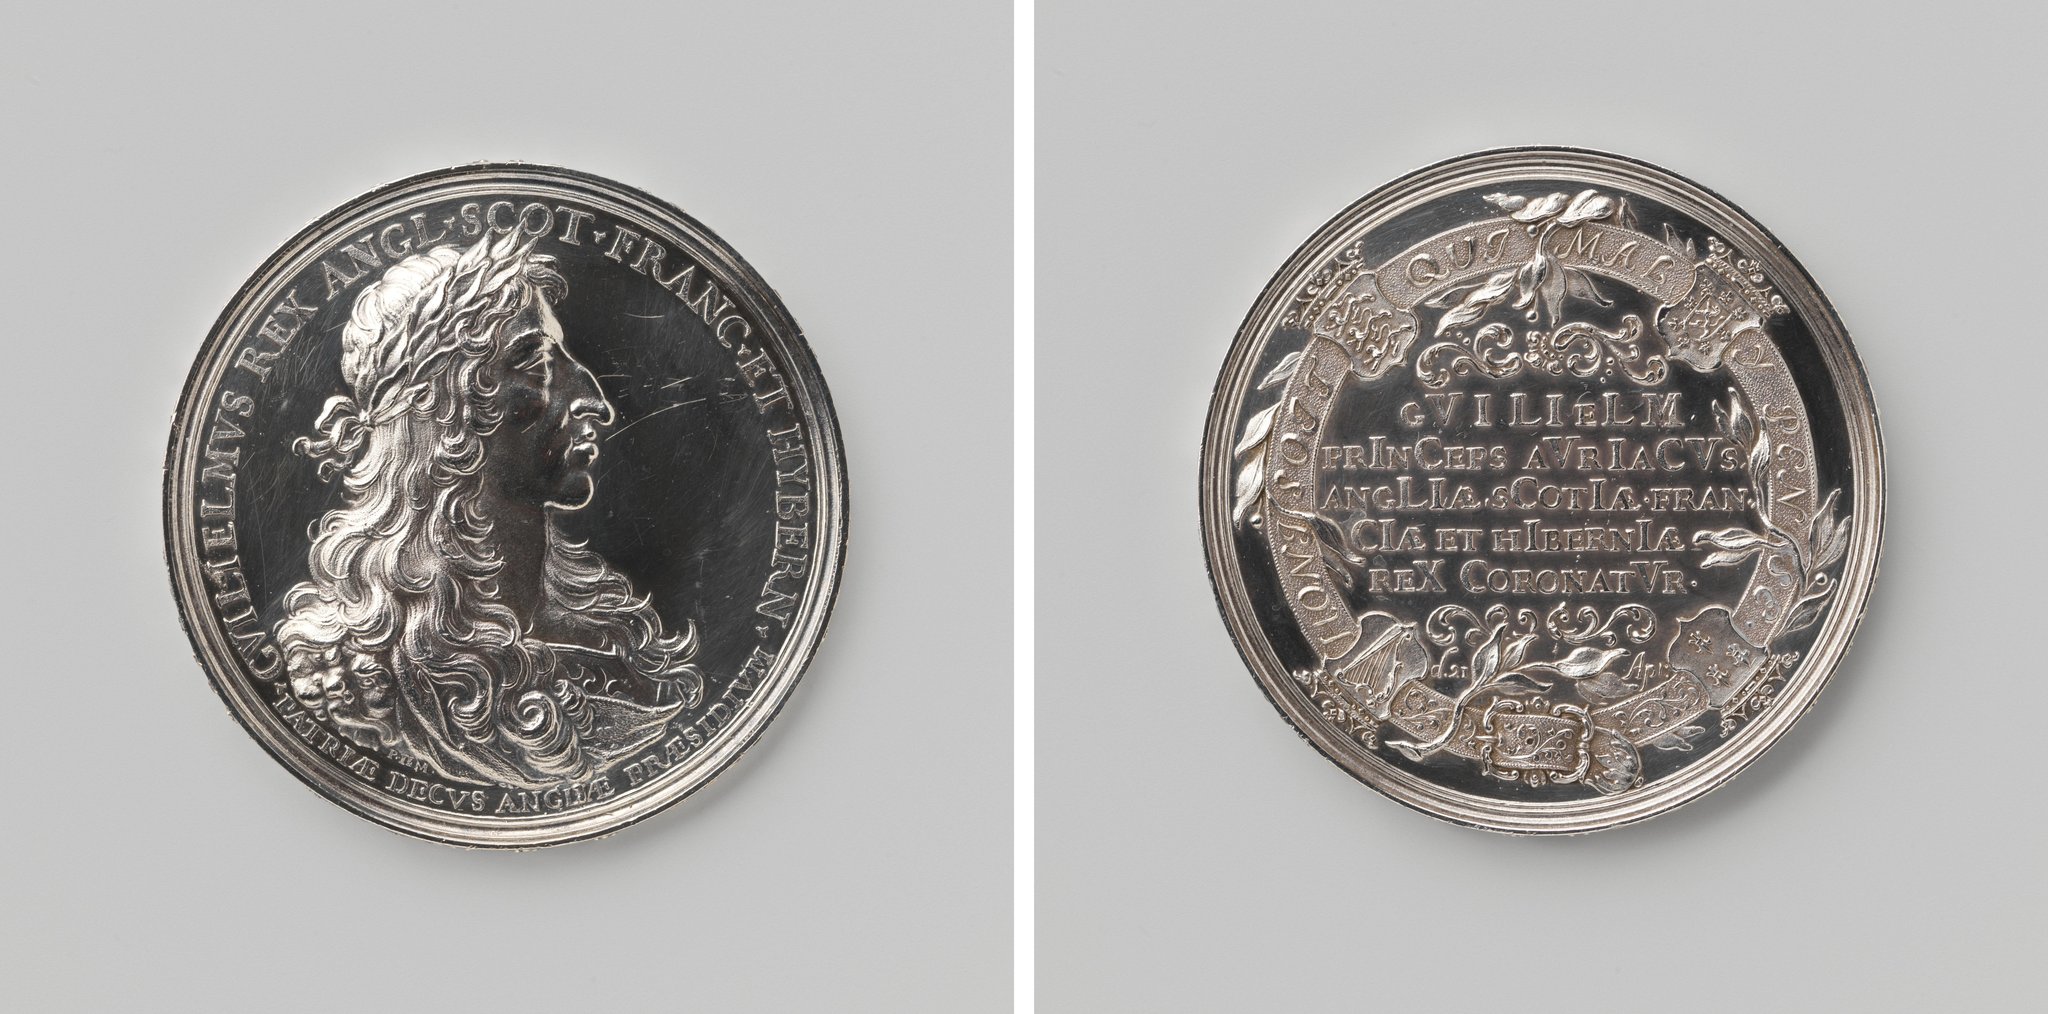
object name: history medal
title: Kroning van Willem III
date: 1689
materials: silver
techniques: striking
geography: nuremberg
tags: william iii (prince of orange and king of england, scotland, and ireland)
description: Zilveren penning. Voorzijde: borststuk man met lauwerkrans binnen omschrift. Keerzijde: opschrift binnen orde van kouseband met vier gekroonde wapenschilden omwonden met takken met oranjeappels; randschrift